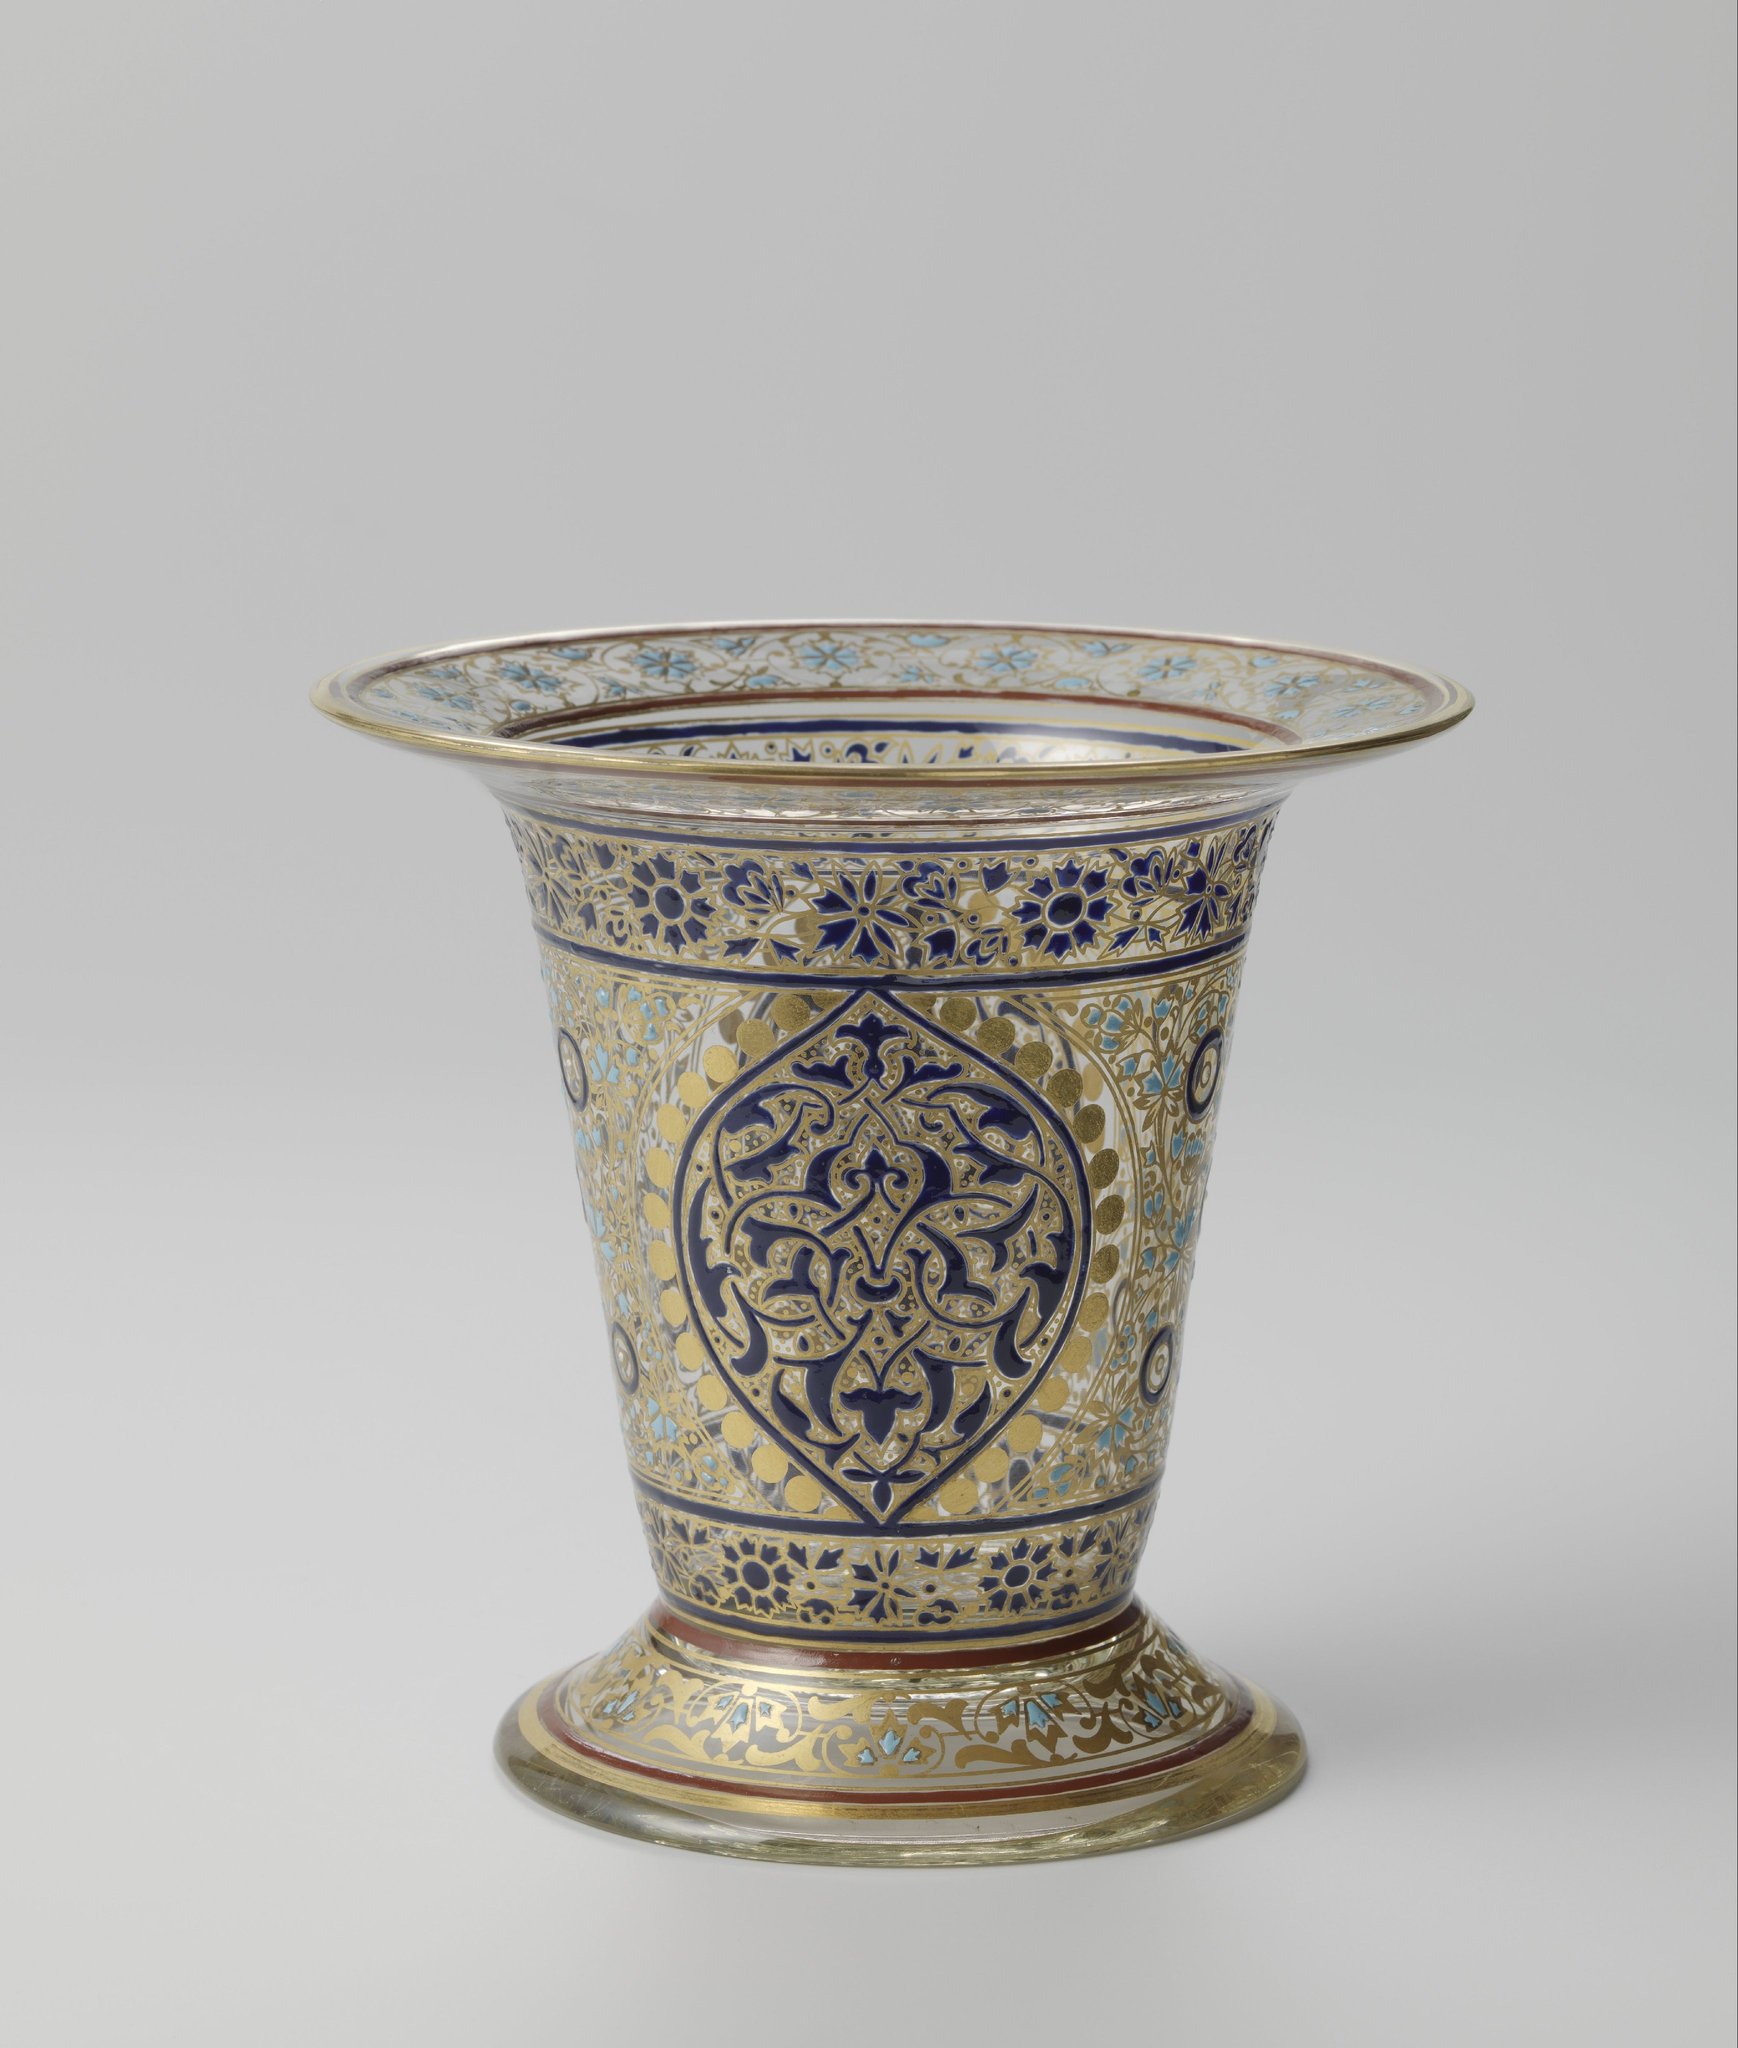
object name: vase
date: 1870-1880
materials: glass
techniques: gilding, glassblowing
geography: bohemia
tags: ornaments ~ art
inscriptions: monogram: ‘JLW’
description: Vaas met gebogen voetrand, conische voet, trechtervormig lichaam, platte en een uitkragende rand. Decoratie in wit, bruin, donker- en lichtblauw en verguldsel in oriëntaliserende motieven. Gemerkt op de bodem in wit email met het monogram JLW (Joseph en Ludwig Wien).